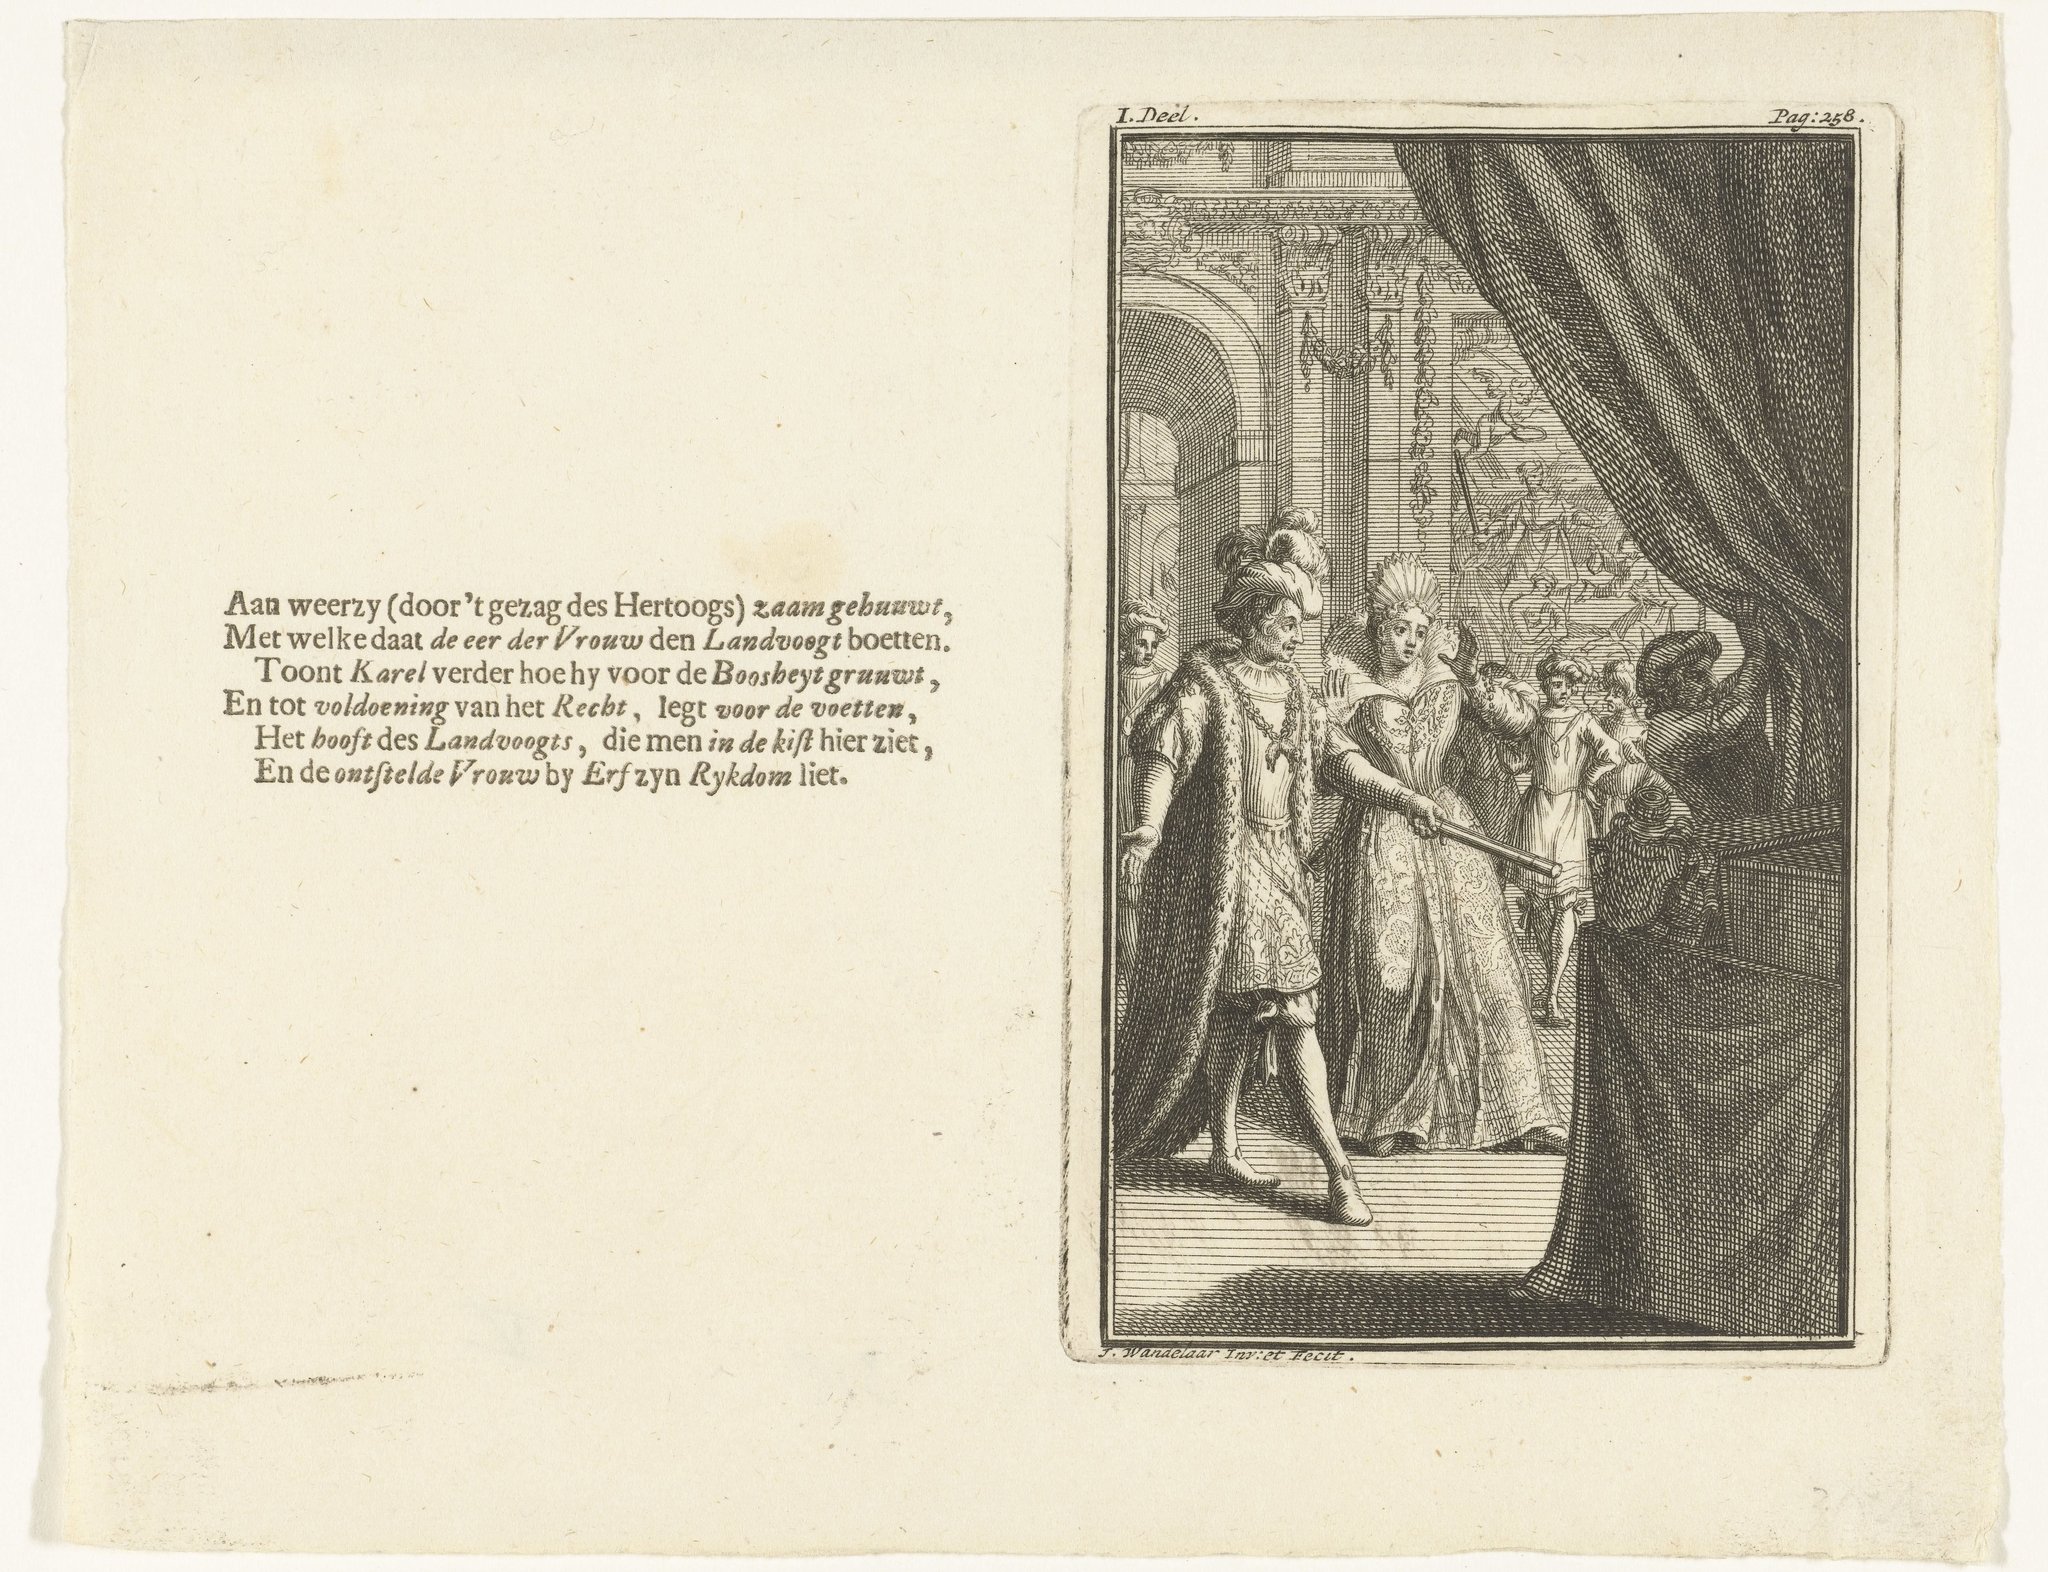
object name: history print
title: De hertog toont Lucreatia haar erfenis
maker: jan wandelaar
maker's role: draughtsman, print maker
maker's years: 1690-1759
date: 1700-1759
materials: paper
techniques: engraving, etching, letterpress printing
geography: northern netherlands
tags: juridical examples; exemplary judges; 'gerechtigkeitsbilder', netherlands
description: Scène uit een toneelstuk naar het verhaal van de rechtspraak van Karel de Stoute over de gouverneur van Zeeland, ca. 1474. Ook bekend als het verhaal van Rhynsault en Saphira. In deze bewerking als de landvoogd en Lucretia. Met links van de voorstelling zes regels begeleidende tekst.